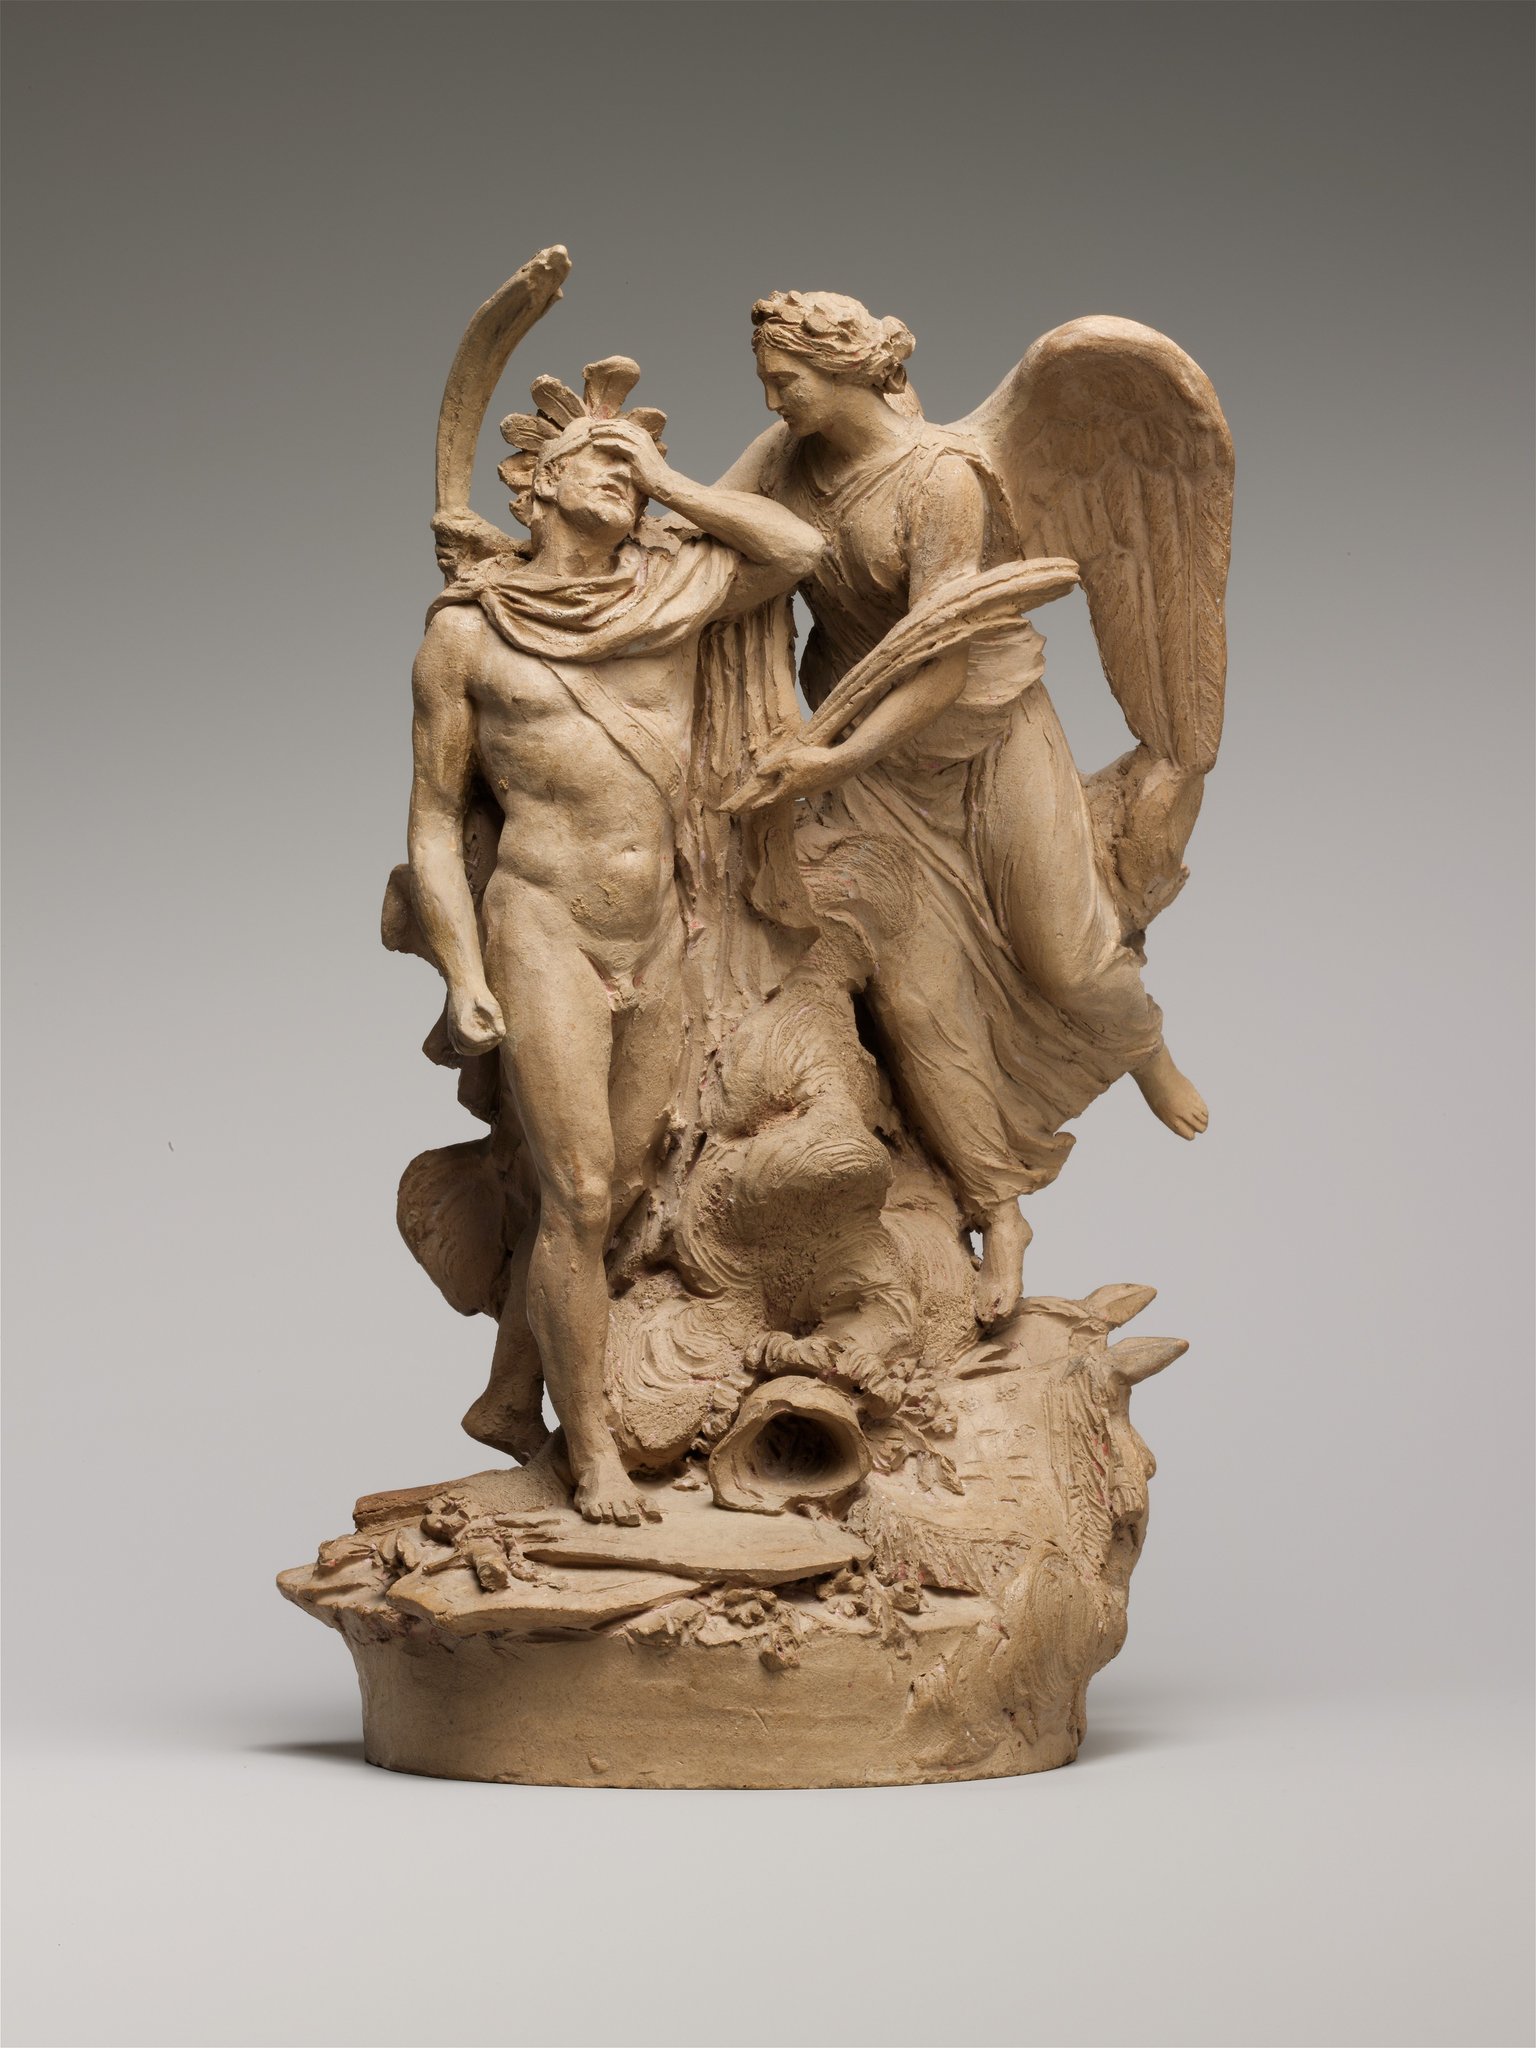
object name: statuette group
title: Allegorical Victory of the Grand Condé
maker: robert guillaume dardel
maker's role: artist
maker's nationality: french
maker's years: 1749-1821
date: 1786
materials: terracotta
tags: louis xiv,victory